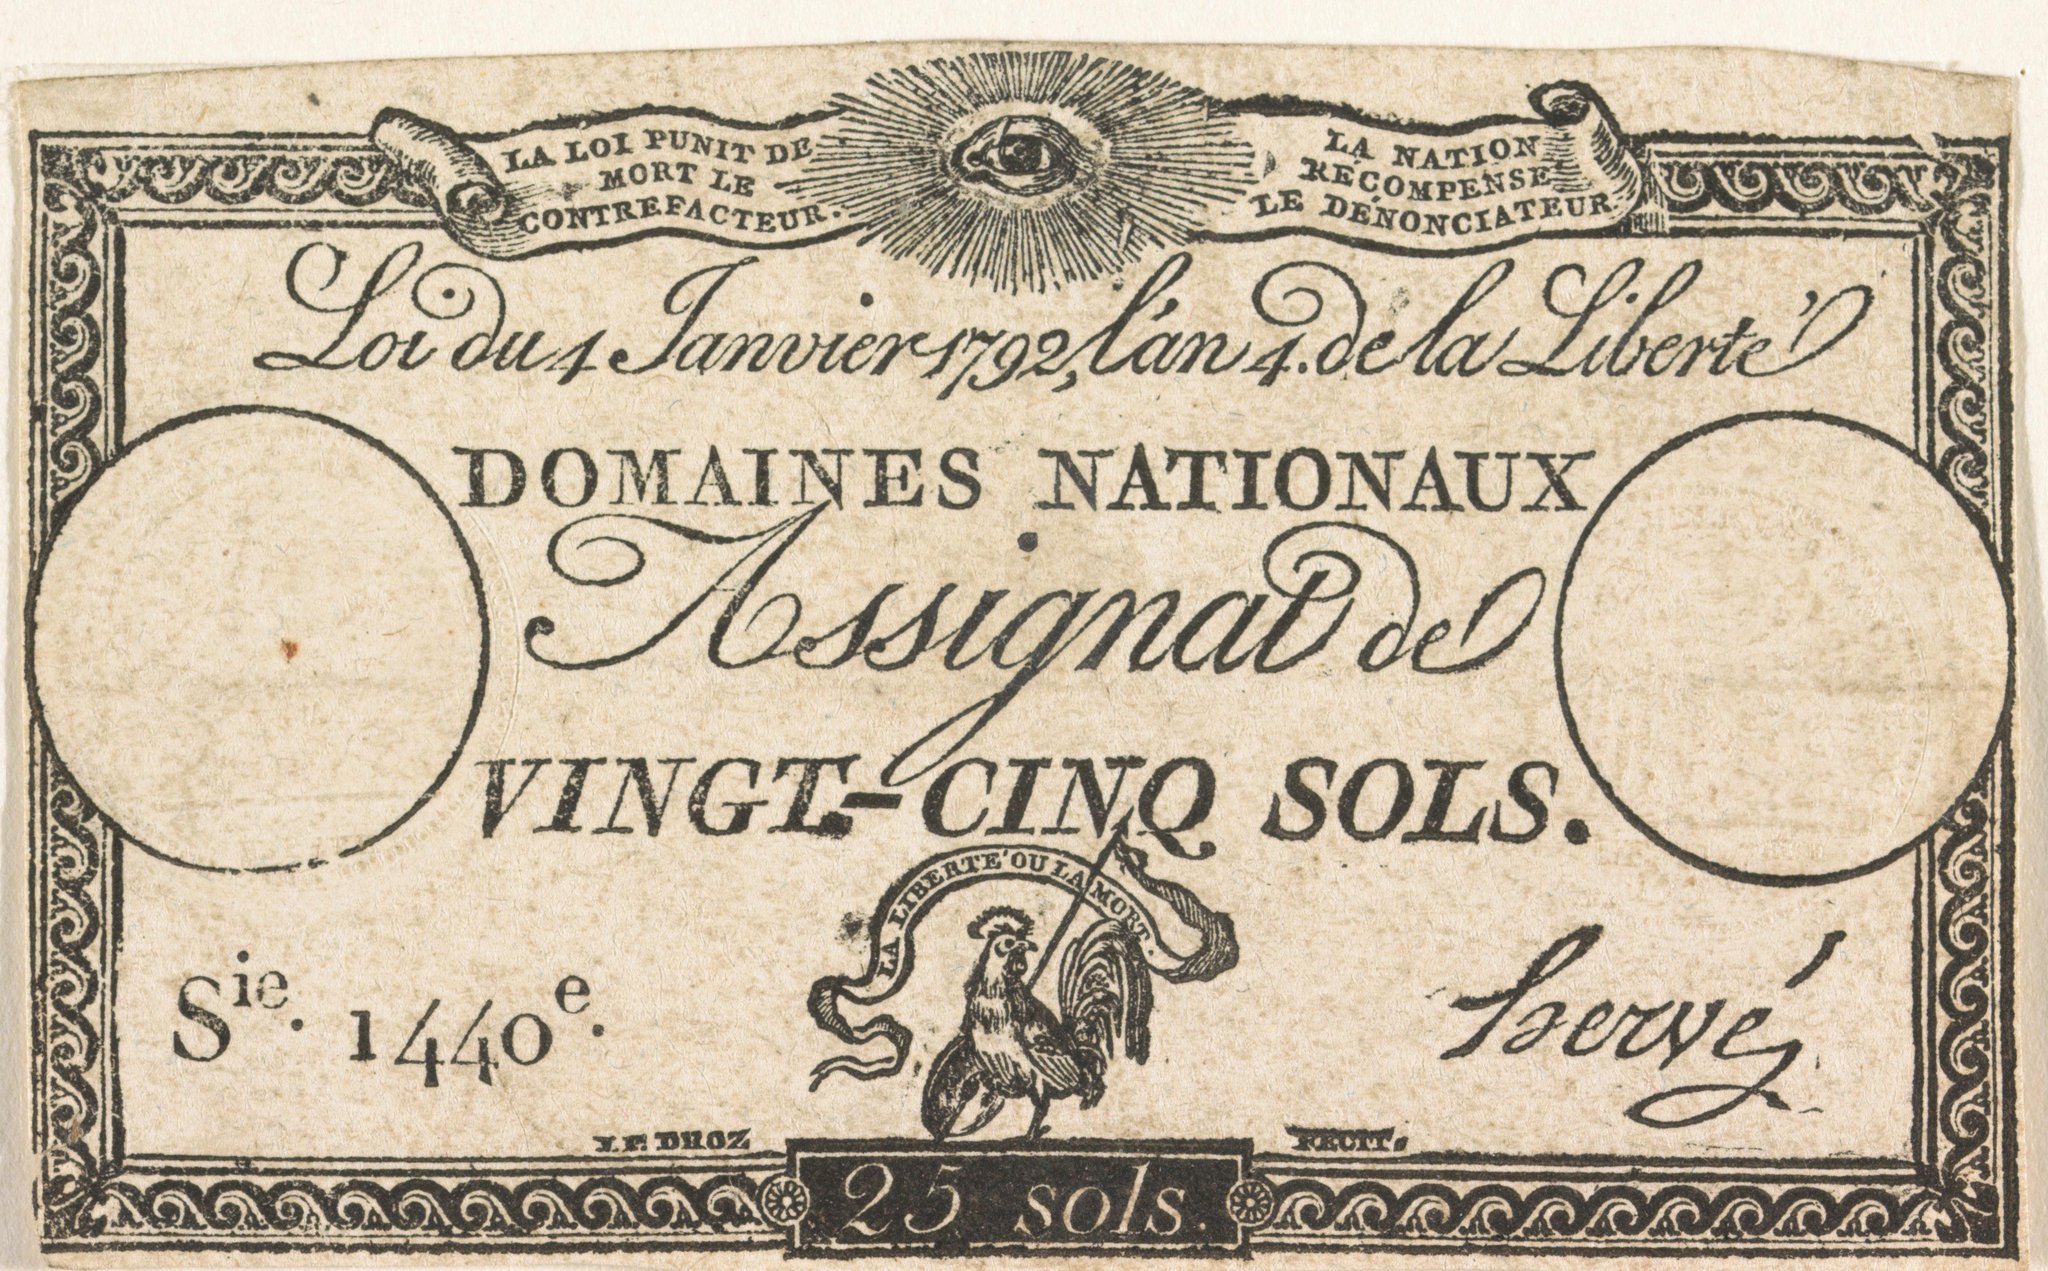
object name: print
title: Assignaat van 25 sols, 1790-1796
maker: jean-pierre droz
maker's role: medailleur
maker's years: 1746-1823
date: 1790-1796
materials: paper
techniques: blind stamped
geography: france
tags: bank-note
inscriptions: collector's mark: Lugt 2228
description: Franse assignaat ter waarde van 25 sols. In omloop gebracht door de Domaines nationaux, serie 1440, zonder datum.